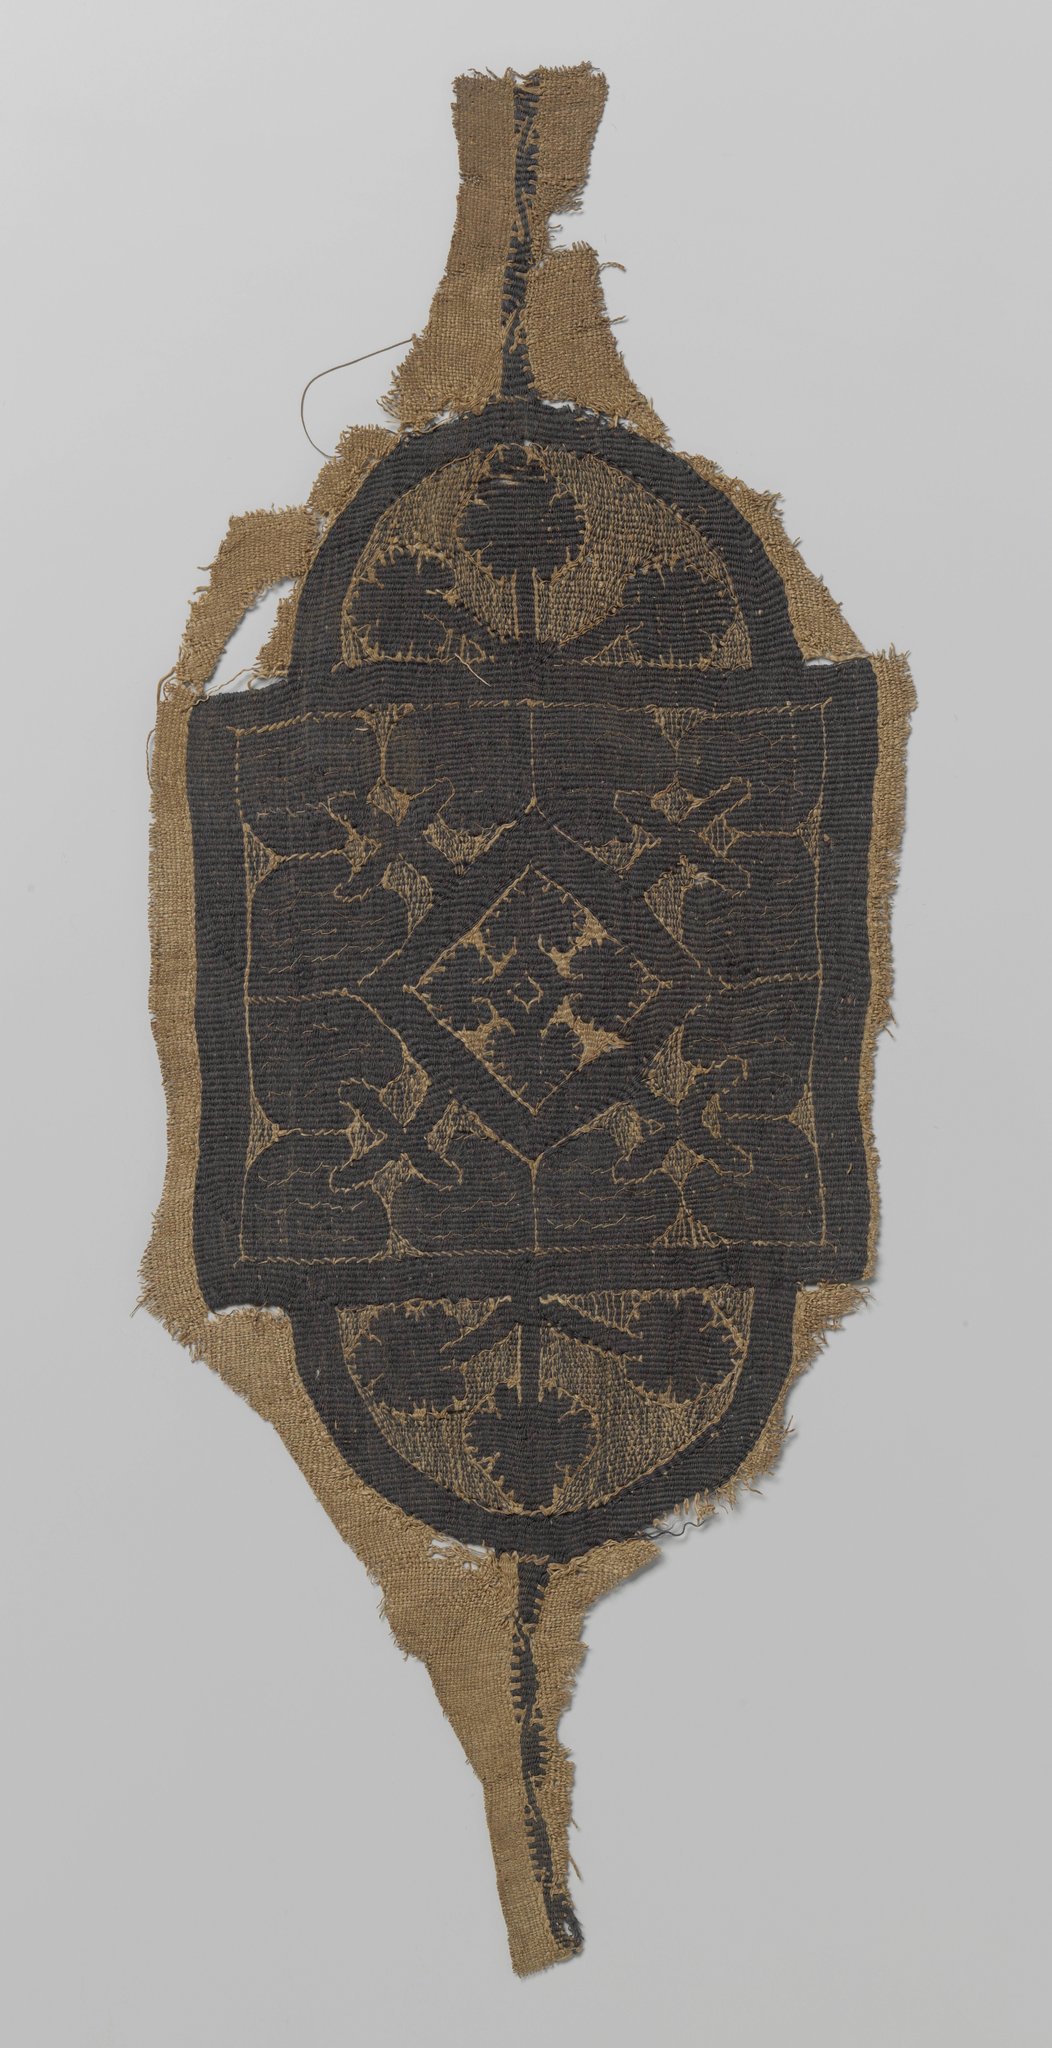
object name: tabula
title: Weefselfragment met tabula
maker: Anonymous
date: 300-499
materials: linen, wool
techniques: weave, tapestry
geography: egypt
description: Okerkleurig linnen weefselfragment met ingeweven patroon in donkerblauwe wol van een vierkant waarbinnen een ruit. Aan twee zijden van het vierkant een halve cirkel, waaruit een getordeerde lijn voortkomt. Vierkant, ruit en halve cirkels gevuld met een groot bladmotief met detaillering in vliegende draadtechniek.